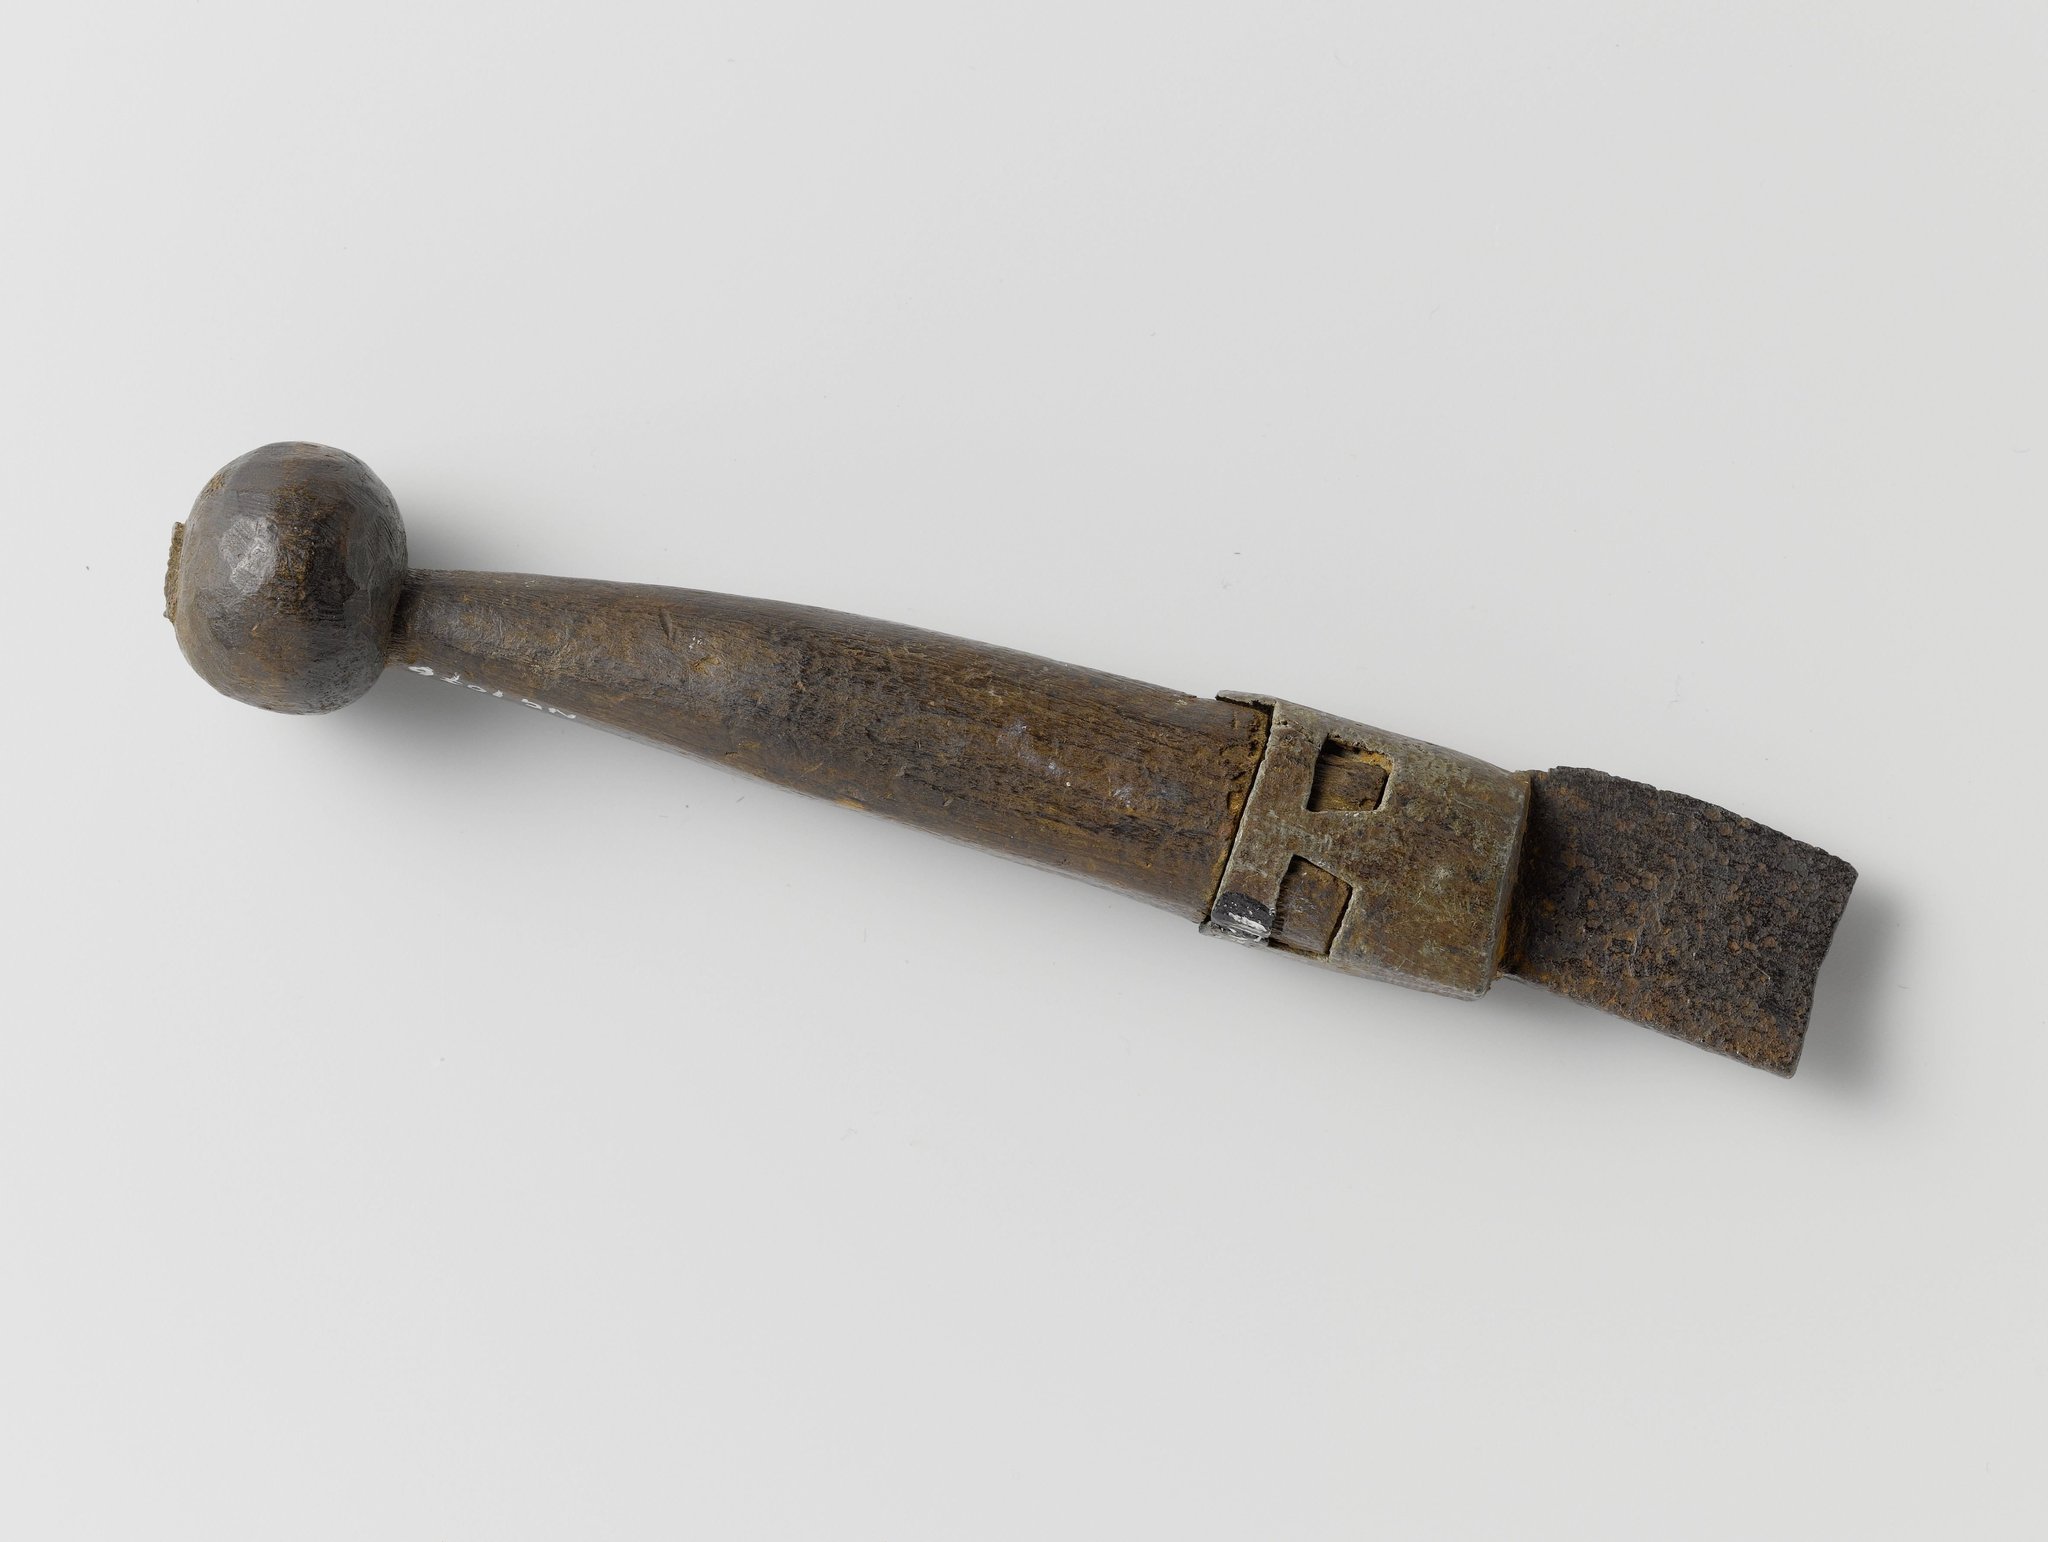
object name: knife tool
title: Heft van hout, spits toelopend met bolvormige knop aan het uiteinde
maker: Anonymous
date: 1590-1596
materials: iron, wood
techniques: cutting, forging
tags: willem barendsz., amsterdam, jacob van heemskerck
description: Rond houten, spits toelopend heft met een bolvormige knop aan het uiteinde. Van het lemmet is een groot gedeelte verdwenen. Het uiteinde van het heft is middels een ijzeren heftbeschermer verstevigd.